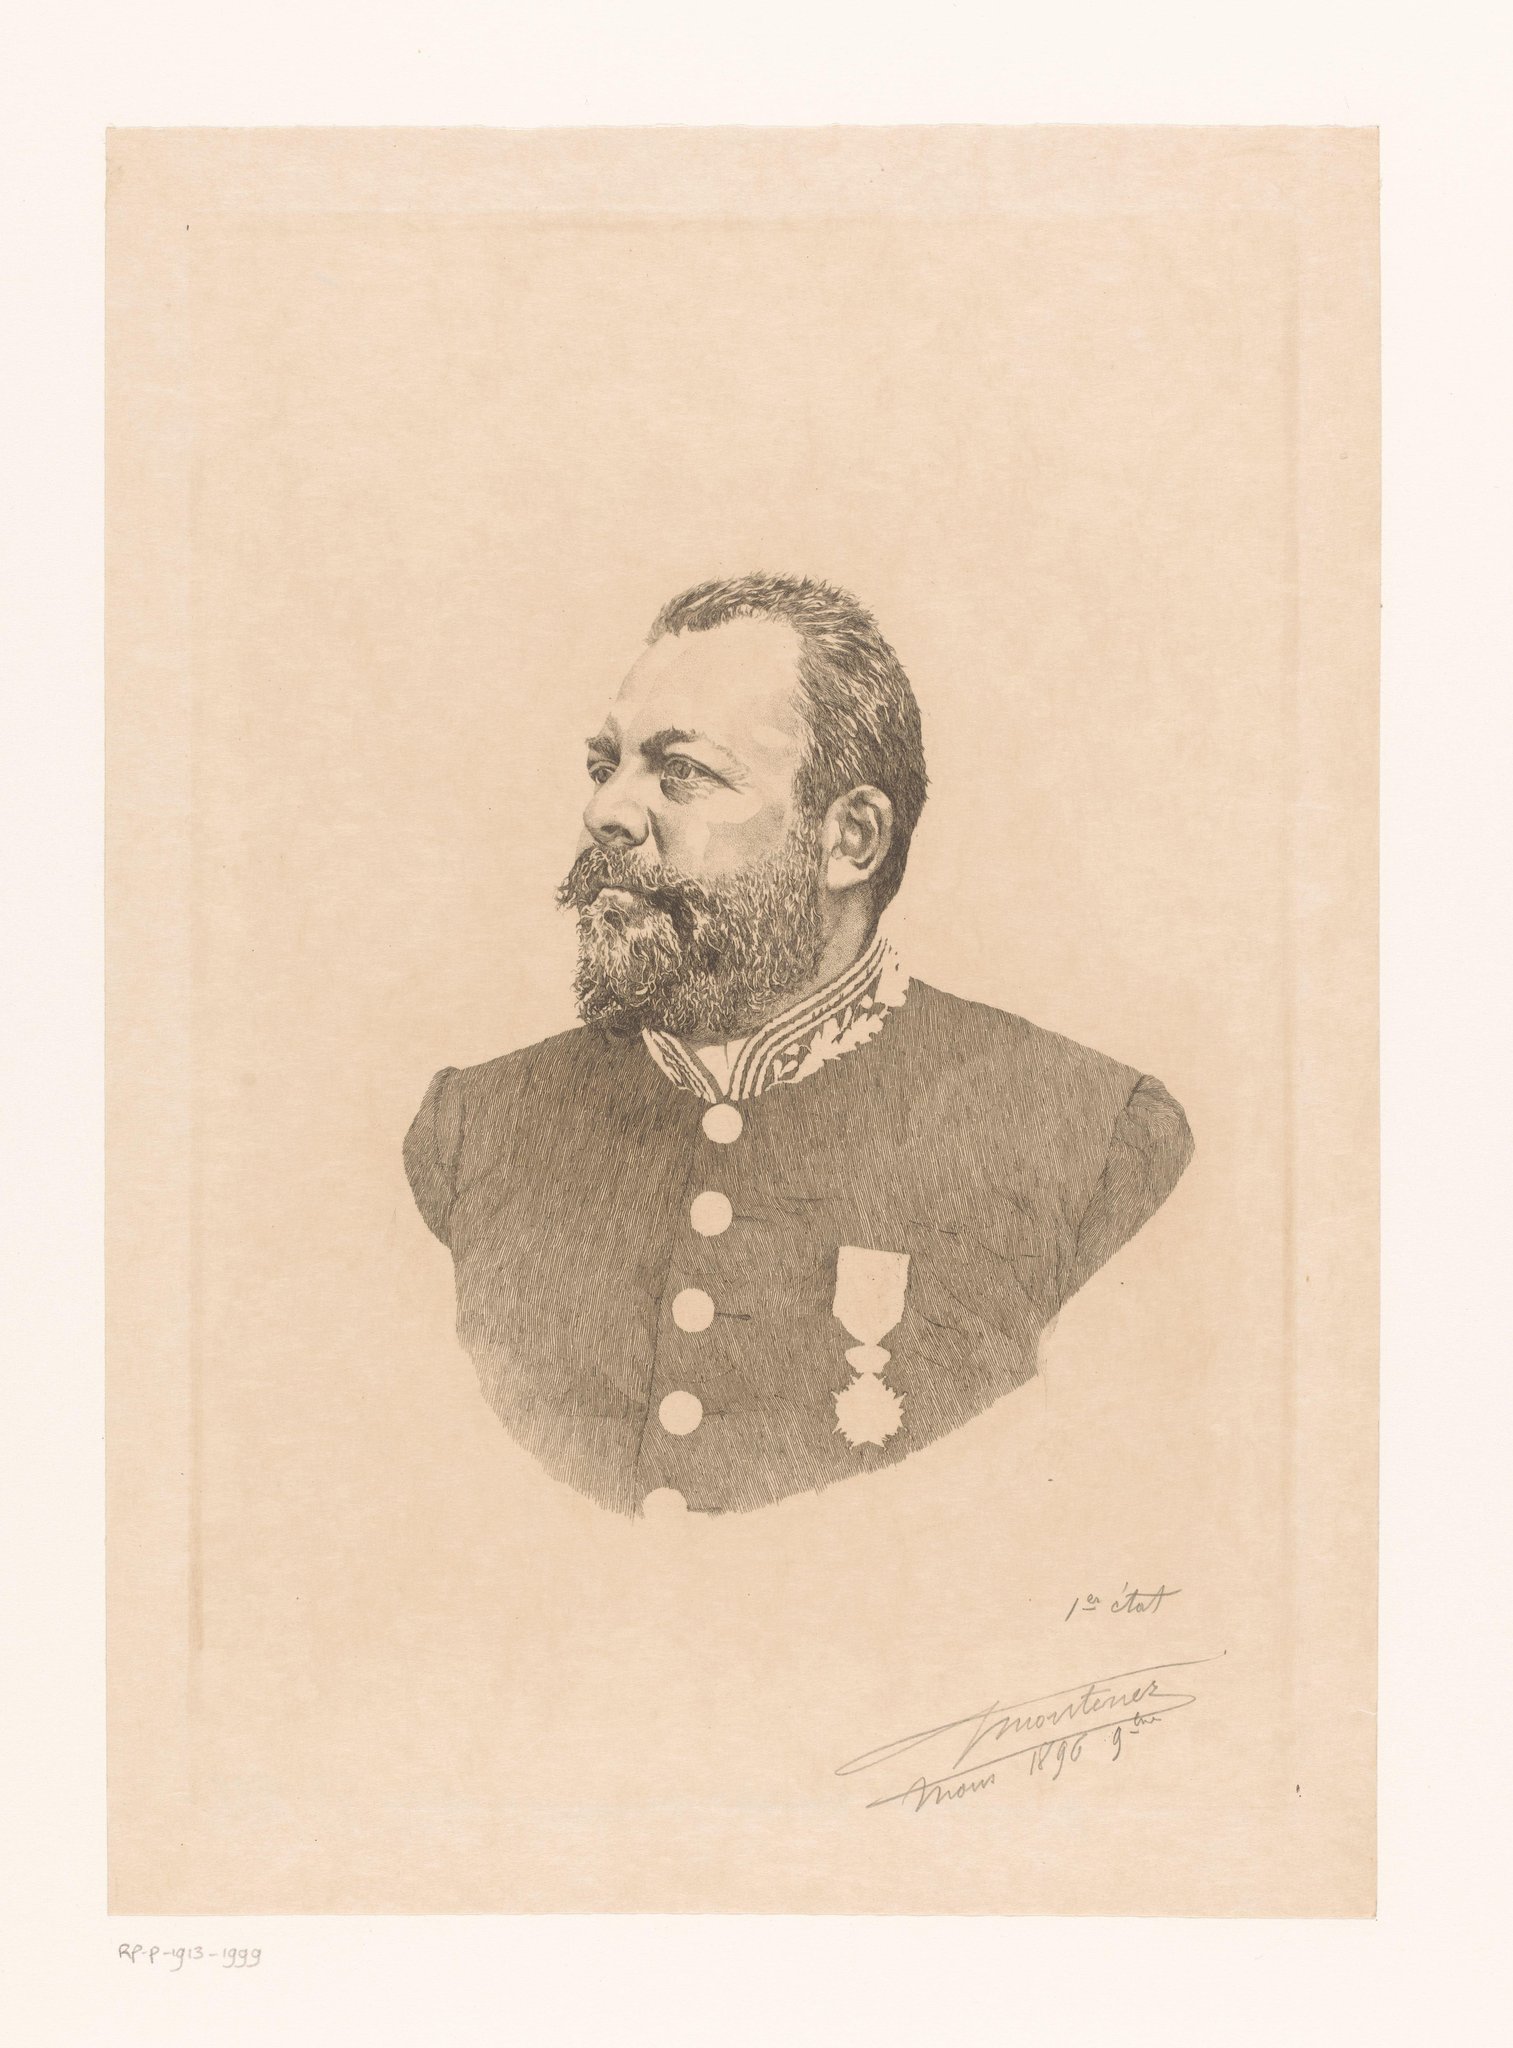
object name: print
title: Portret van Henri Sainctelette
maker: georges montenez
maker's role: print maker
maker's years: 1873-1930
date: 1896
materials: paper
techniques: etching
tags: adult man, historical persons, beard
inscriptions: inscription: ‘1er état; Mons 1896 9m’, collector's mark: Lugt 2228